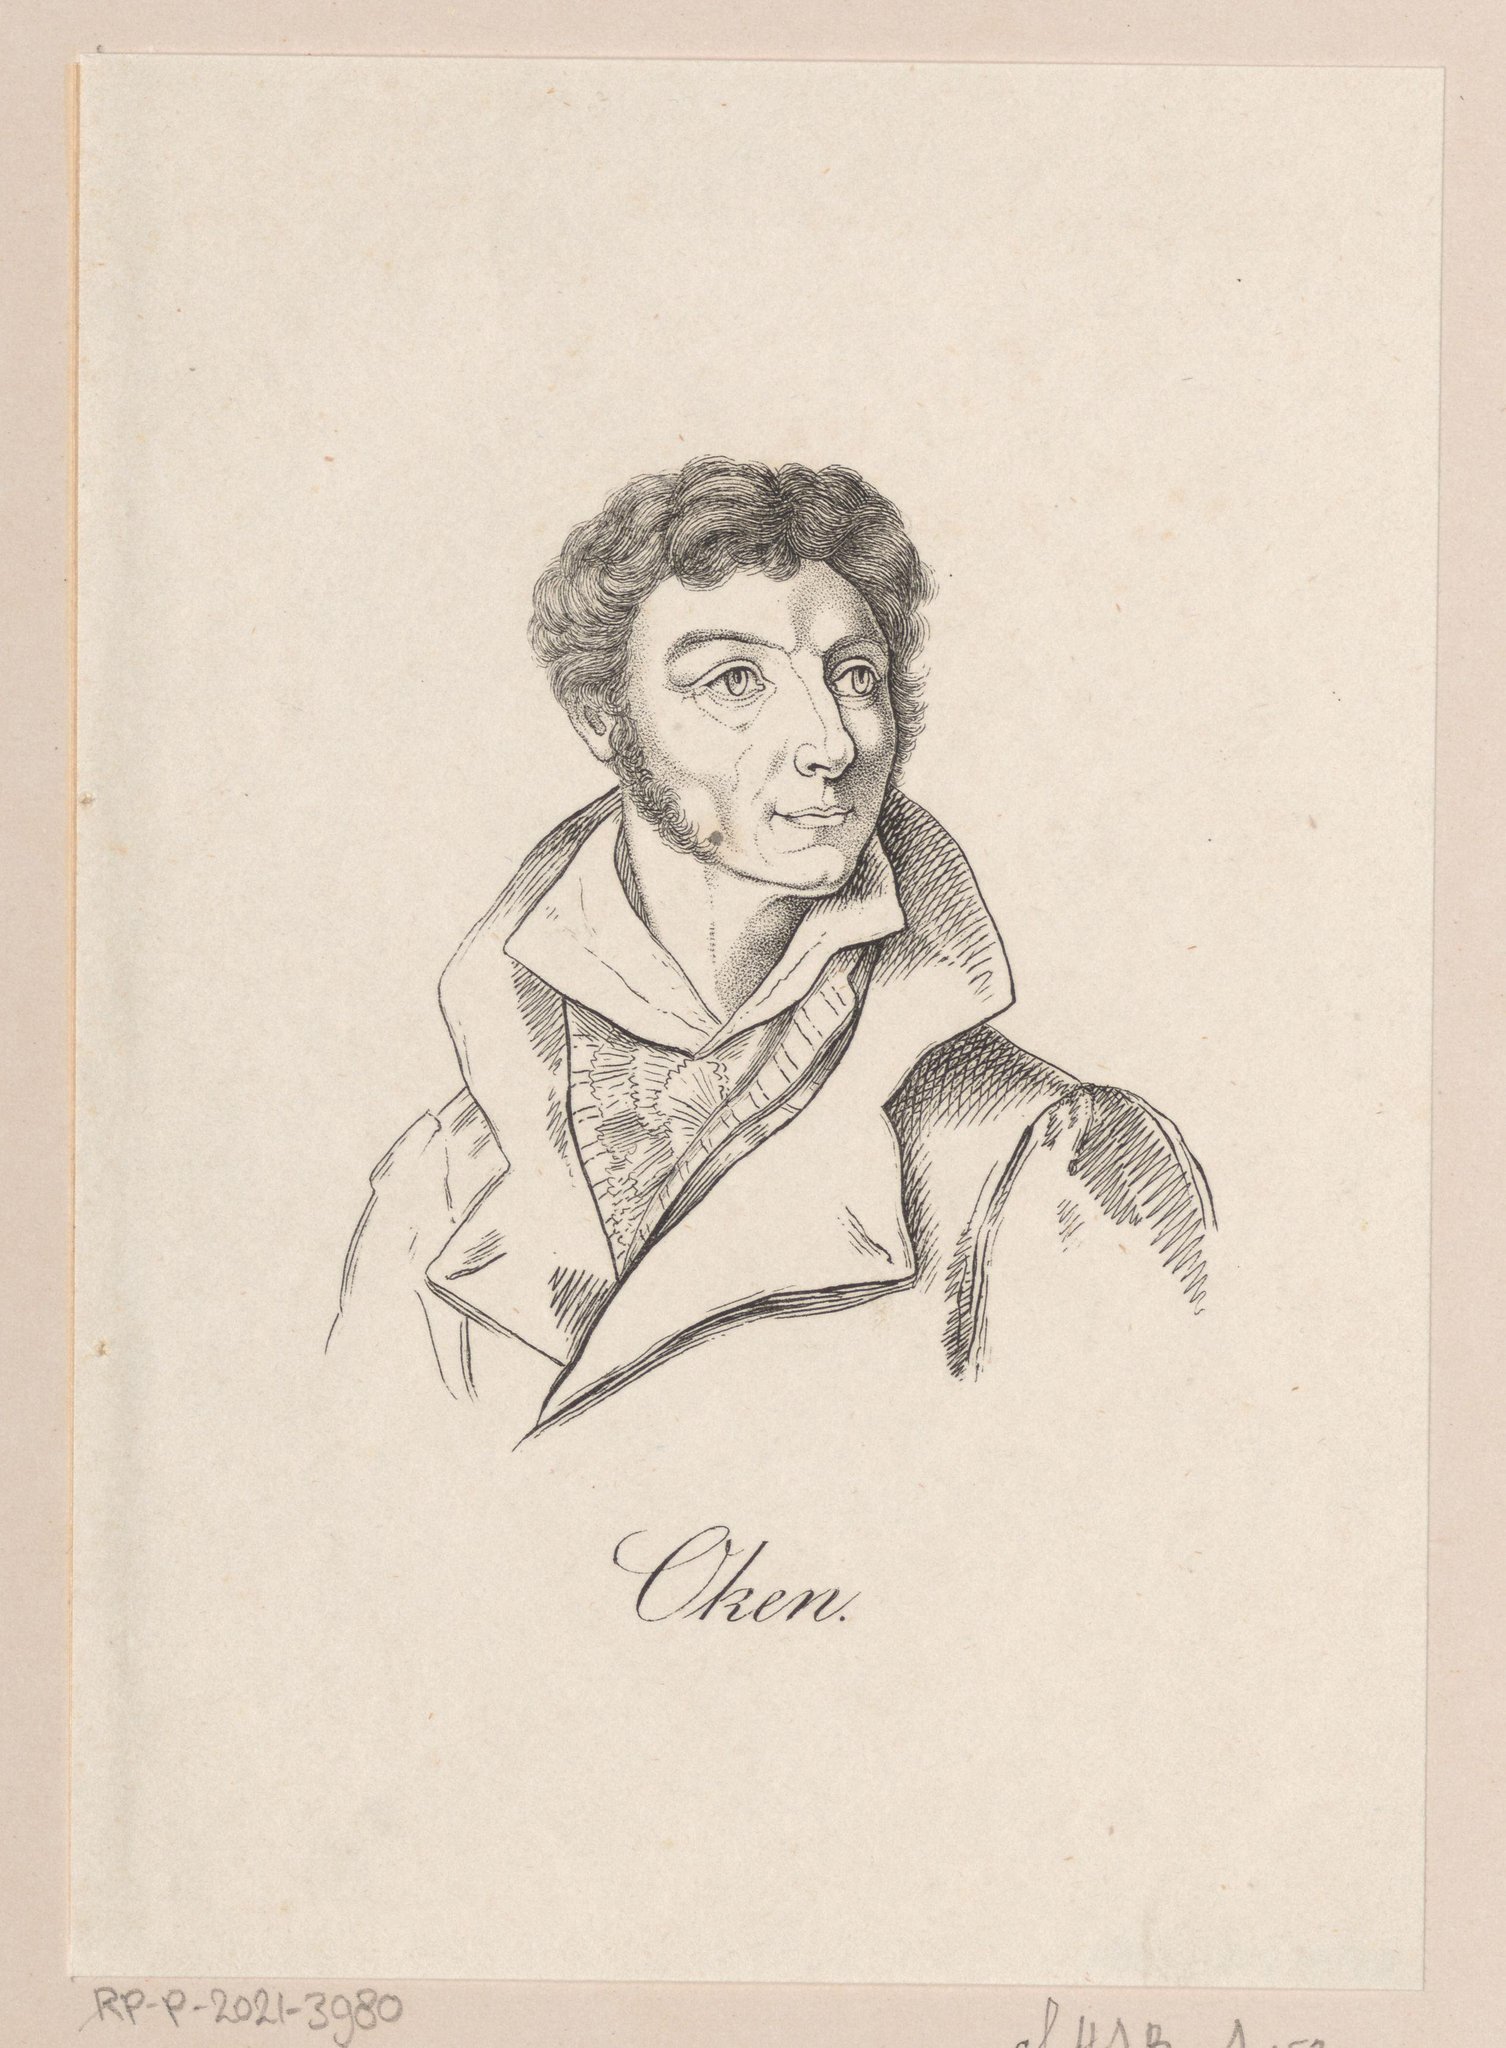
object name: print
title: Portret van Lorenz Oken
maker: Anonymous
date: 1800-1849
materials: paper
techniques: etching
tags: historical persons